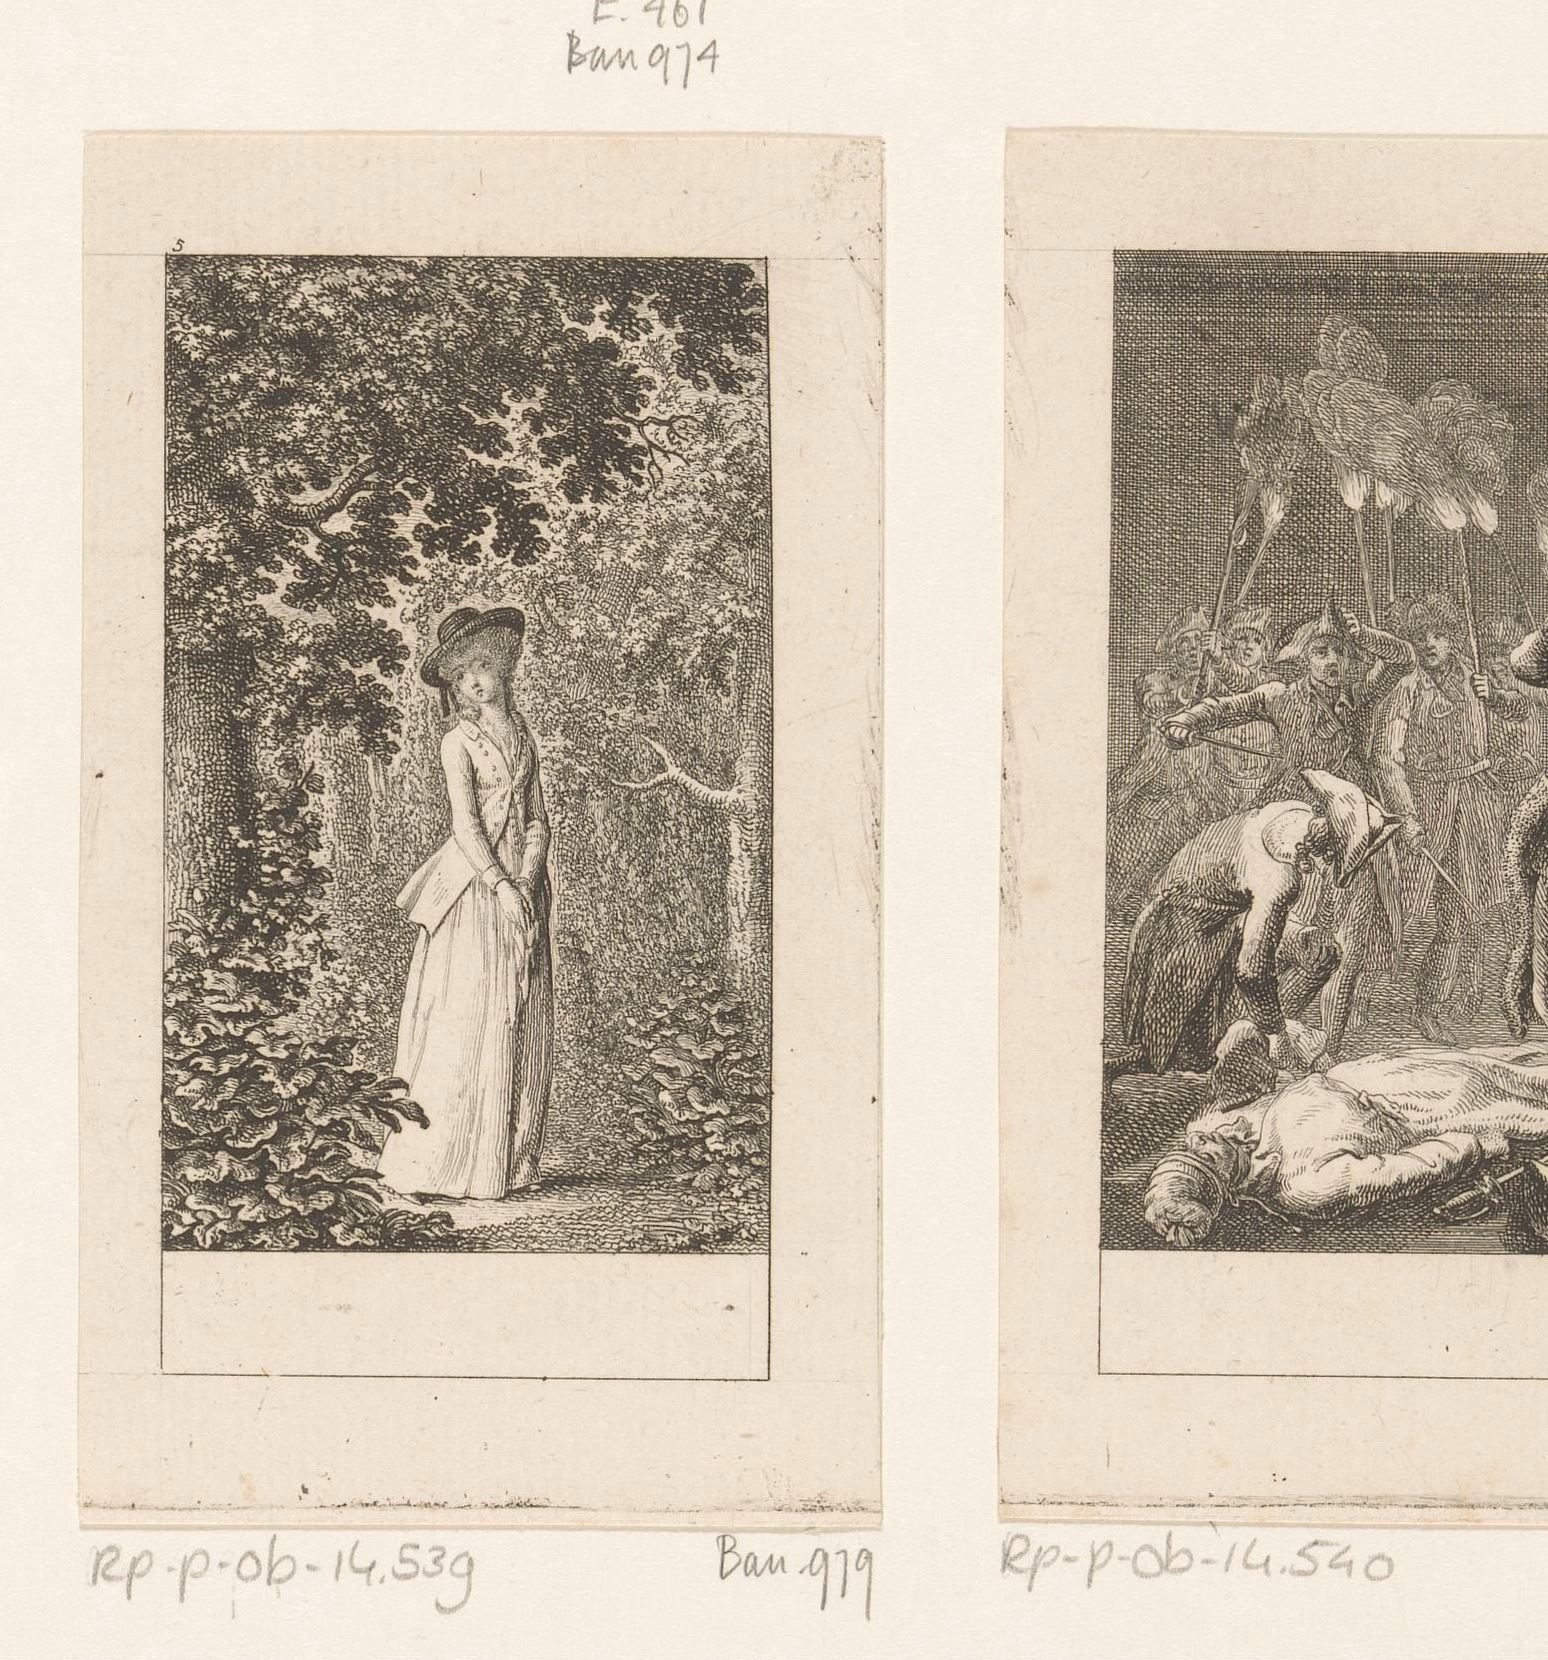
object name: print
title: Amalia alleen in de tuin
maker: daniel nikolaus chodowiecki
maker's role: draughtsman, print maker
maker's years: 1726-1801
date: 1782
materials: paper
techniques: etching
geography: berlin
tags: friedrich von schiller, adolescent, young woman, maiden, literature, garden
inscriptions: collector's mark: Lugt 2228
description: Vervaardigd voor Friedrich von Schillers 'Räubern'. Latere staat gebruikt voor: Theater-Calender, oder Taschenbuch für die Schaubühne. Gotha: Ettinger, 1783.